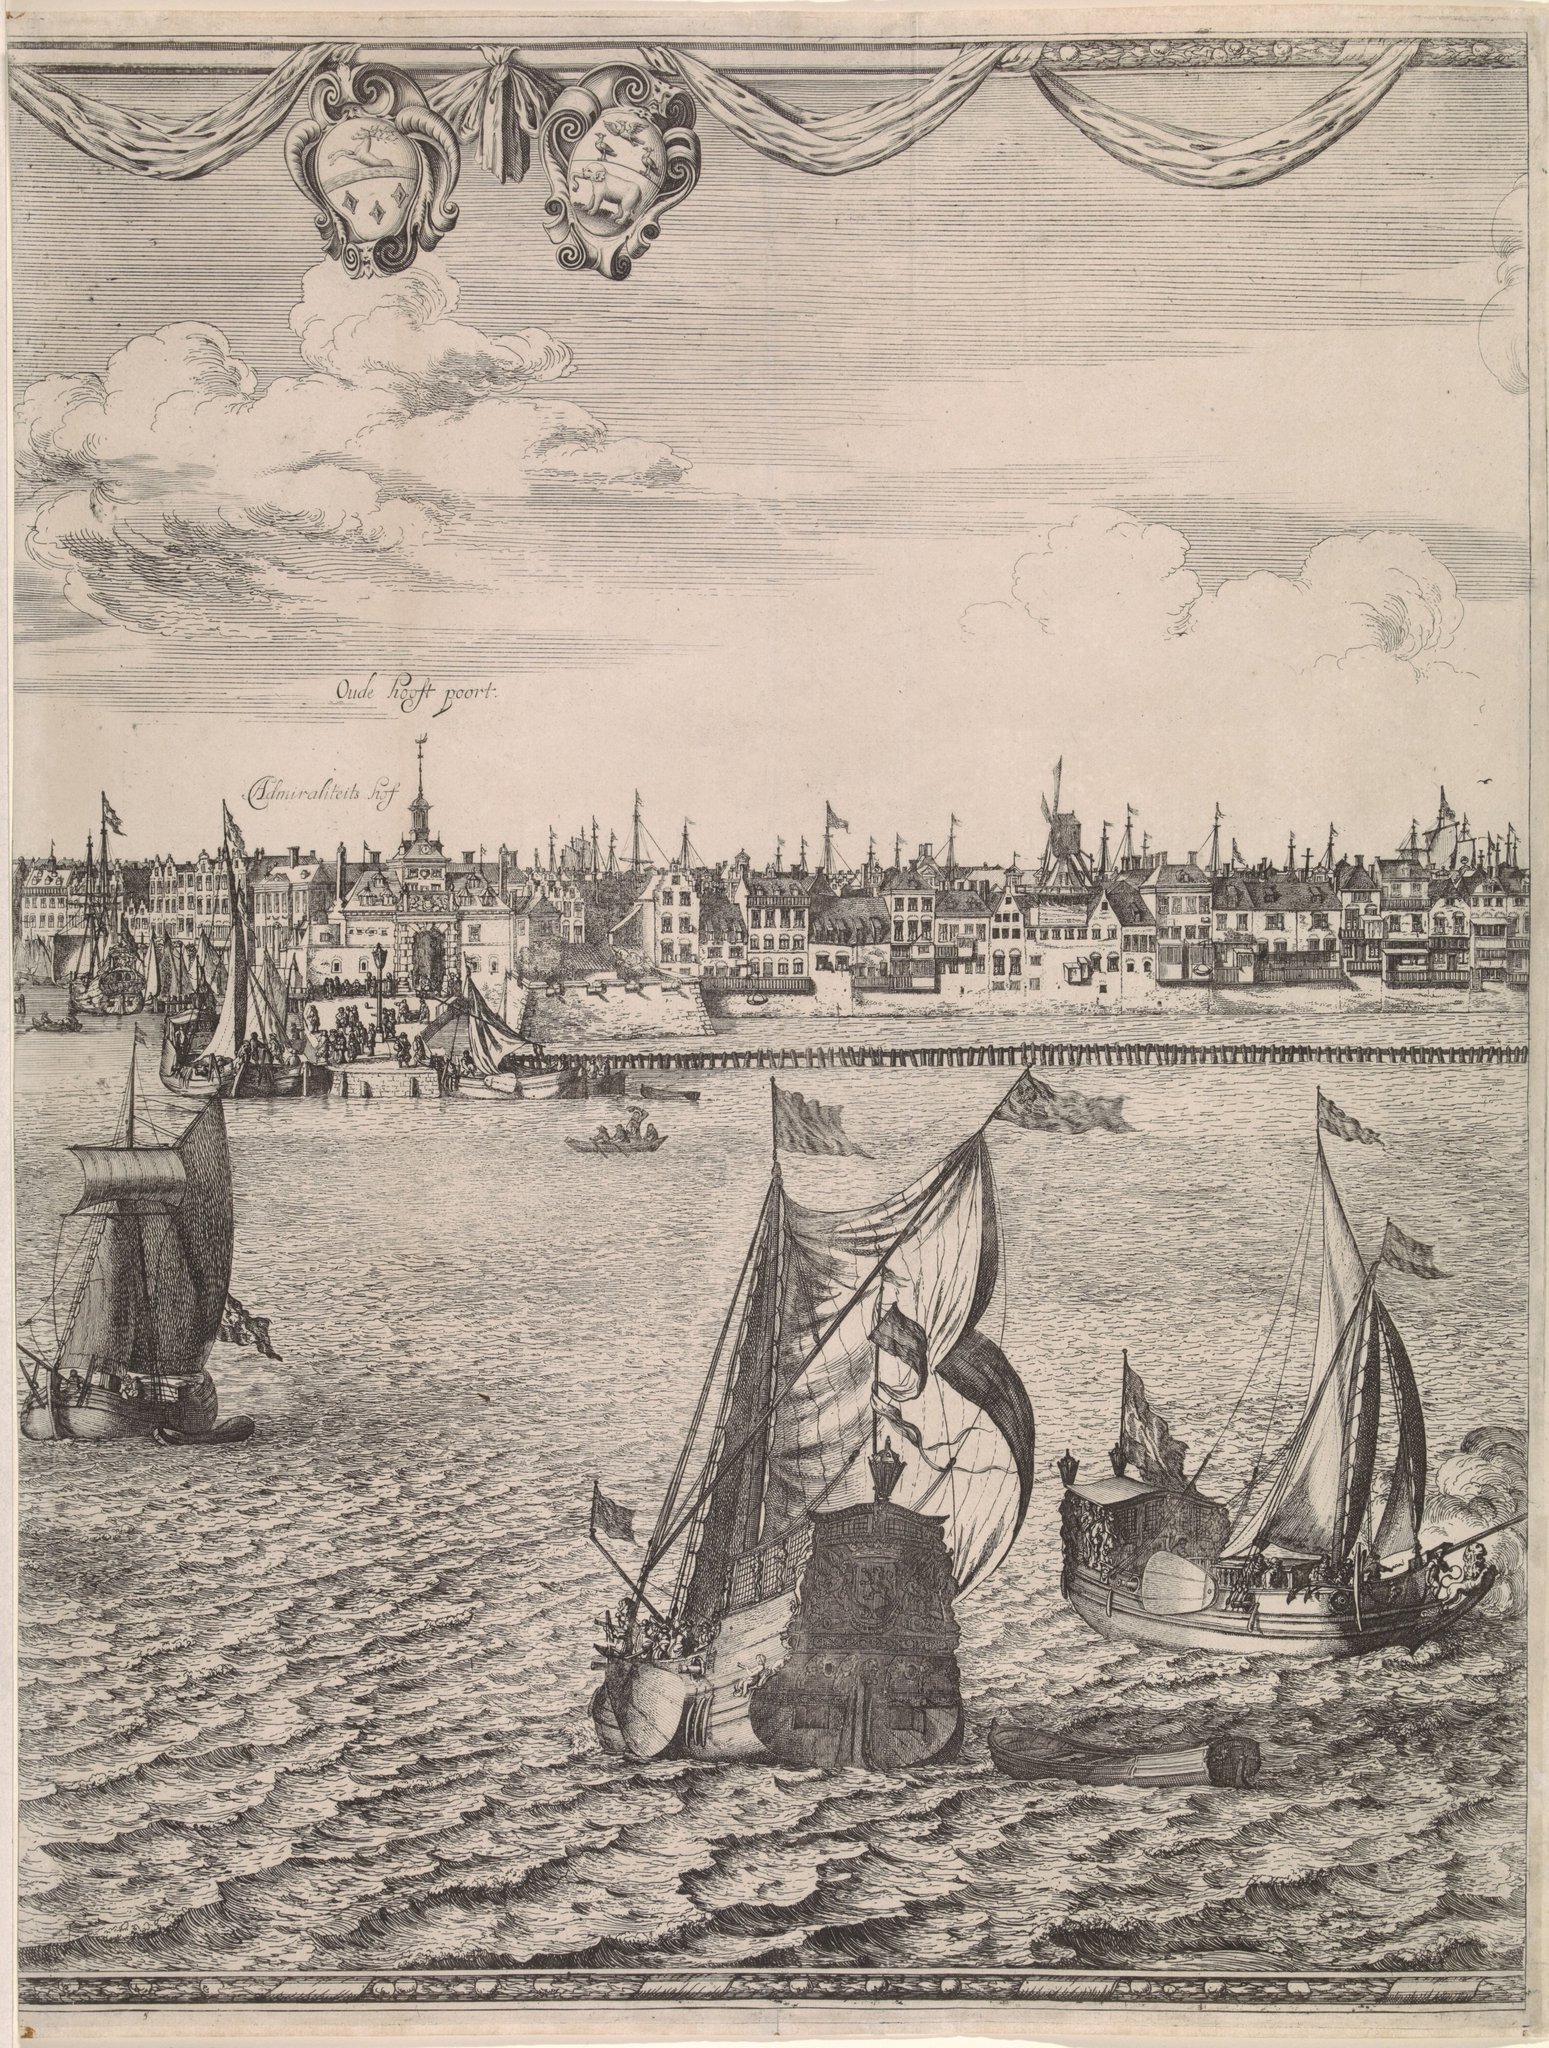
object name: print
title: Rotterodamum Hollandiae urbs celeberrima et situ portibusque mercaturae opportunissima. Ao. 1665 (Maaskaart)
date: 1666-1698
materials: paper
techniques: engraving, etching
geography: rotterdam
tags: sailing-ship, sailing-boat, city-gate, city-view in general; 'veduta' (+ city(-scape) with figures, staffage), prospect of city, town panorama, silhouette of city, armorial bearing, heraldry, rotterdam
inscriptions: collector's mark: Lugt 2228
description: Vijfde deel van een gezicht op Rotterdam.